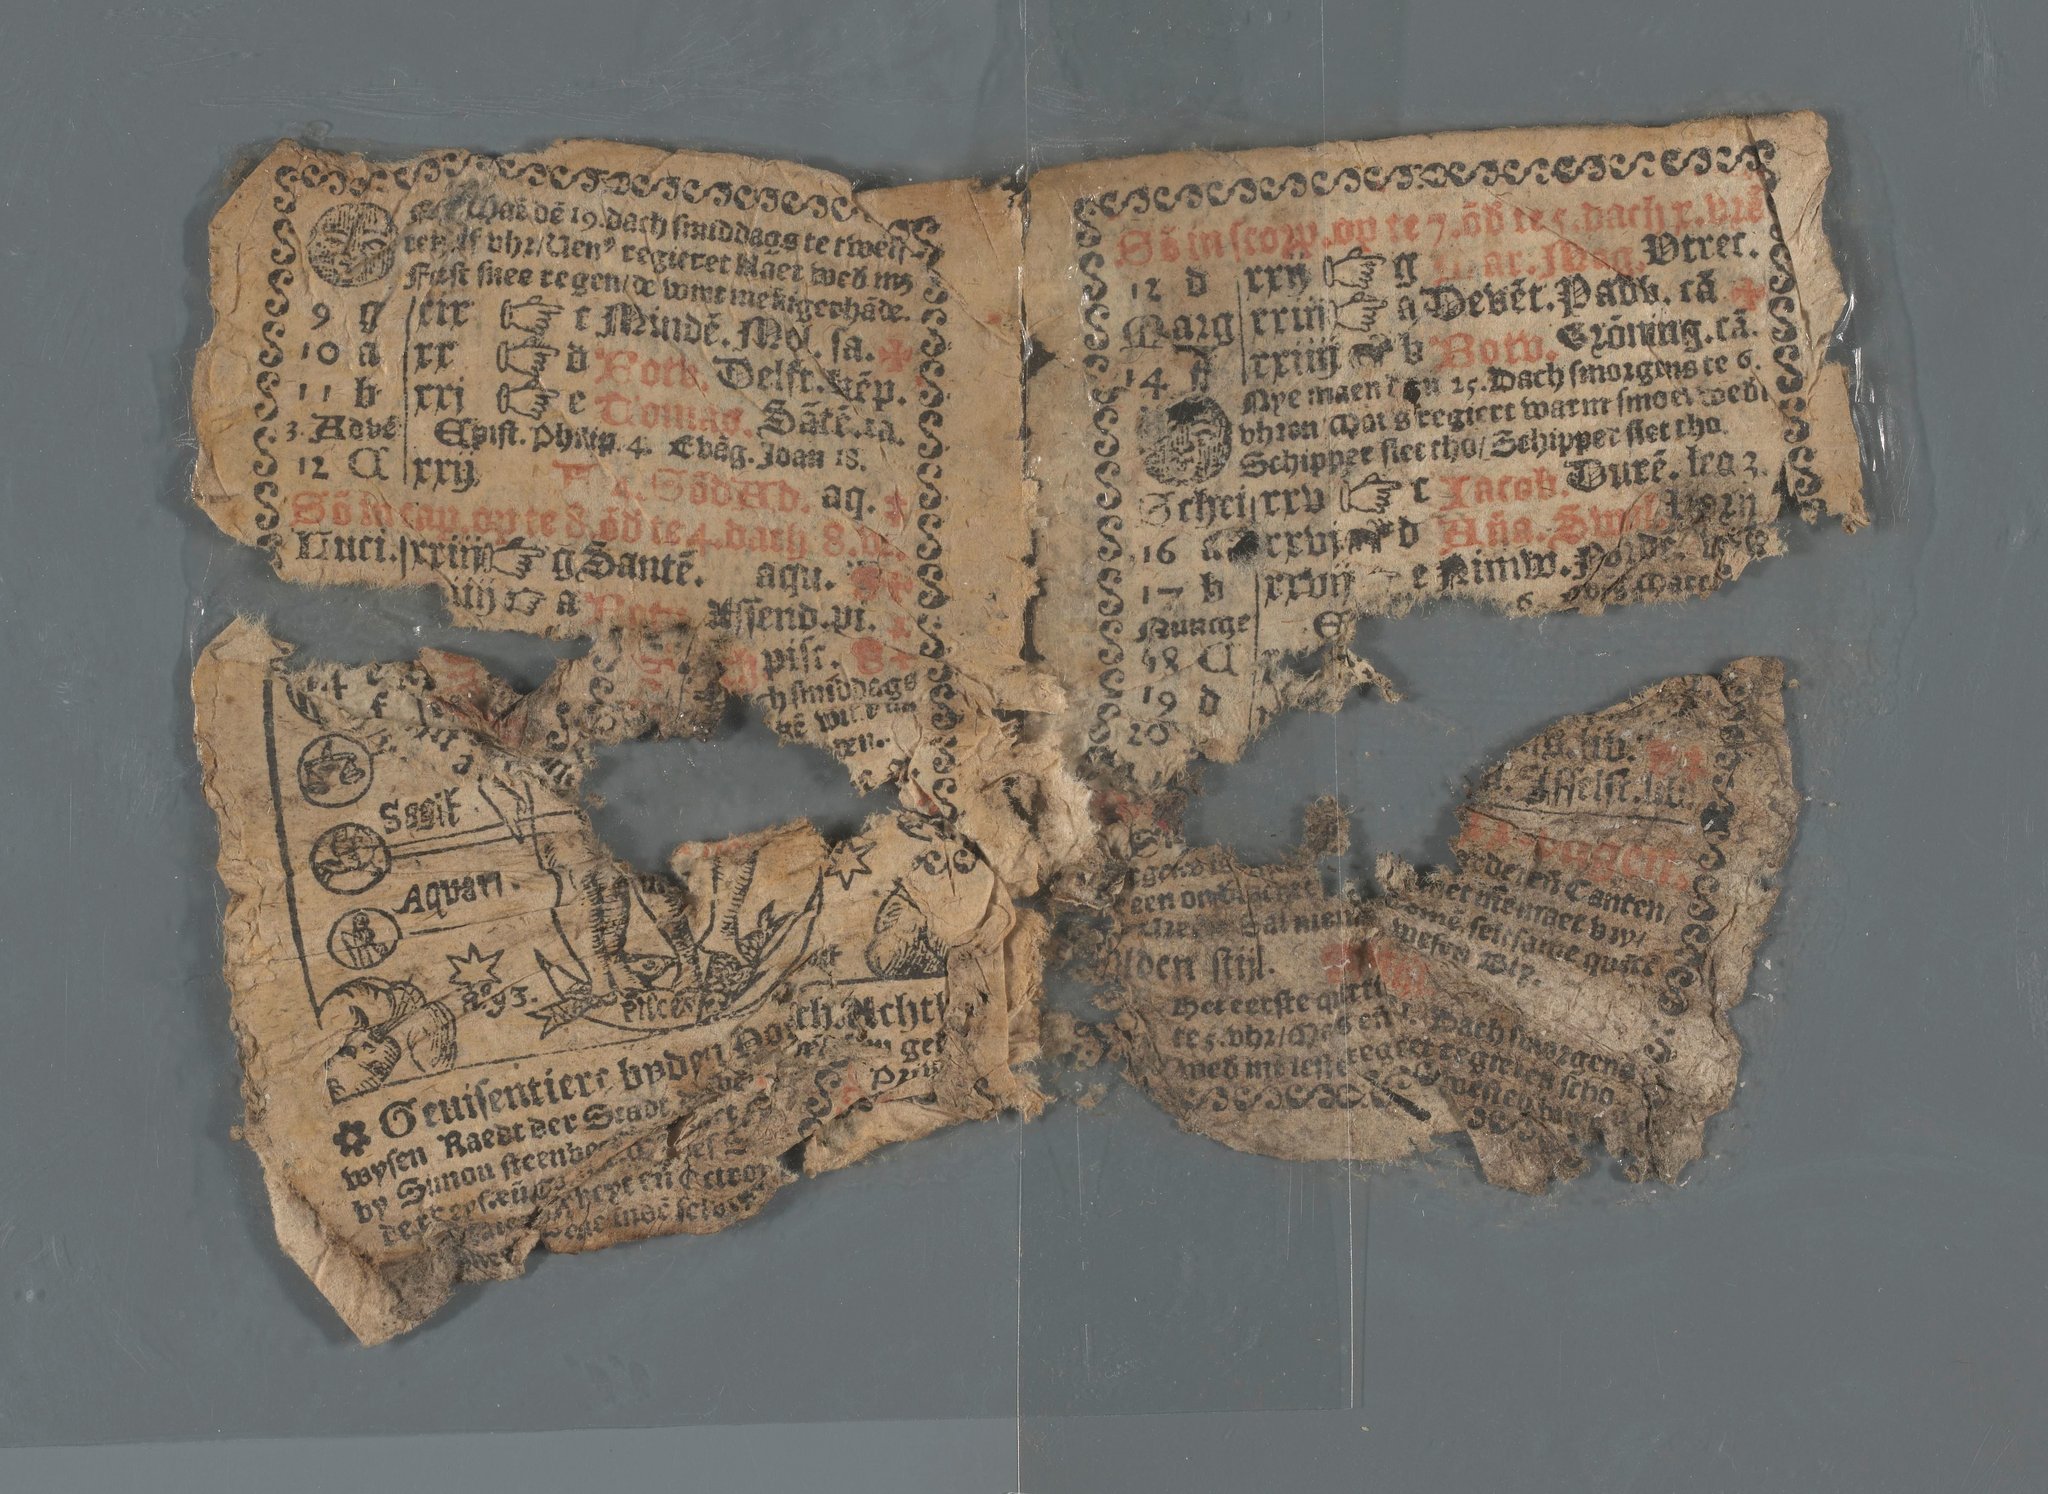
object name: almanac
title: Bladzijde uit een Deventer almanak voor het schrikkeljaar 1596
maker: Anonymous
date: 1596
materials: paper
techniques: printing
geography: enkhuizen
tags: willem barendsz., amsterdam, jacob van heemskerck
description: Bladzijde uit een Deventer almanak voor het schrikkeljaar 1596. Achter- en voorkant.